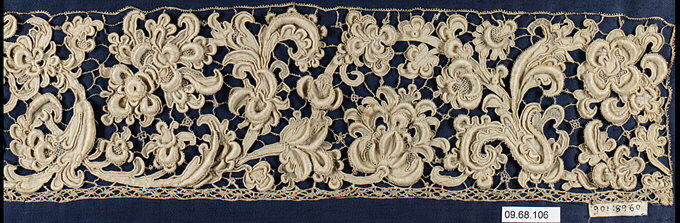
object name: border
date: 1634-1666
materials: lace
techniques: gros point, lace